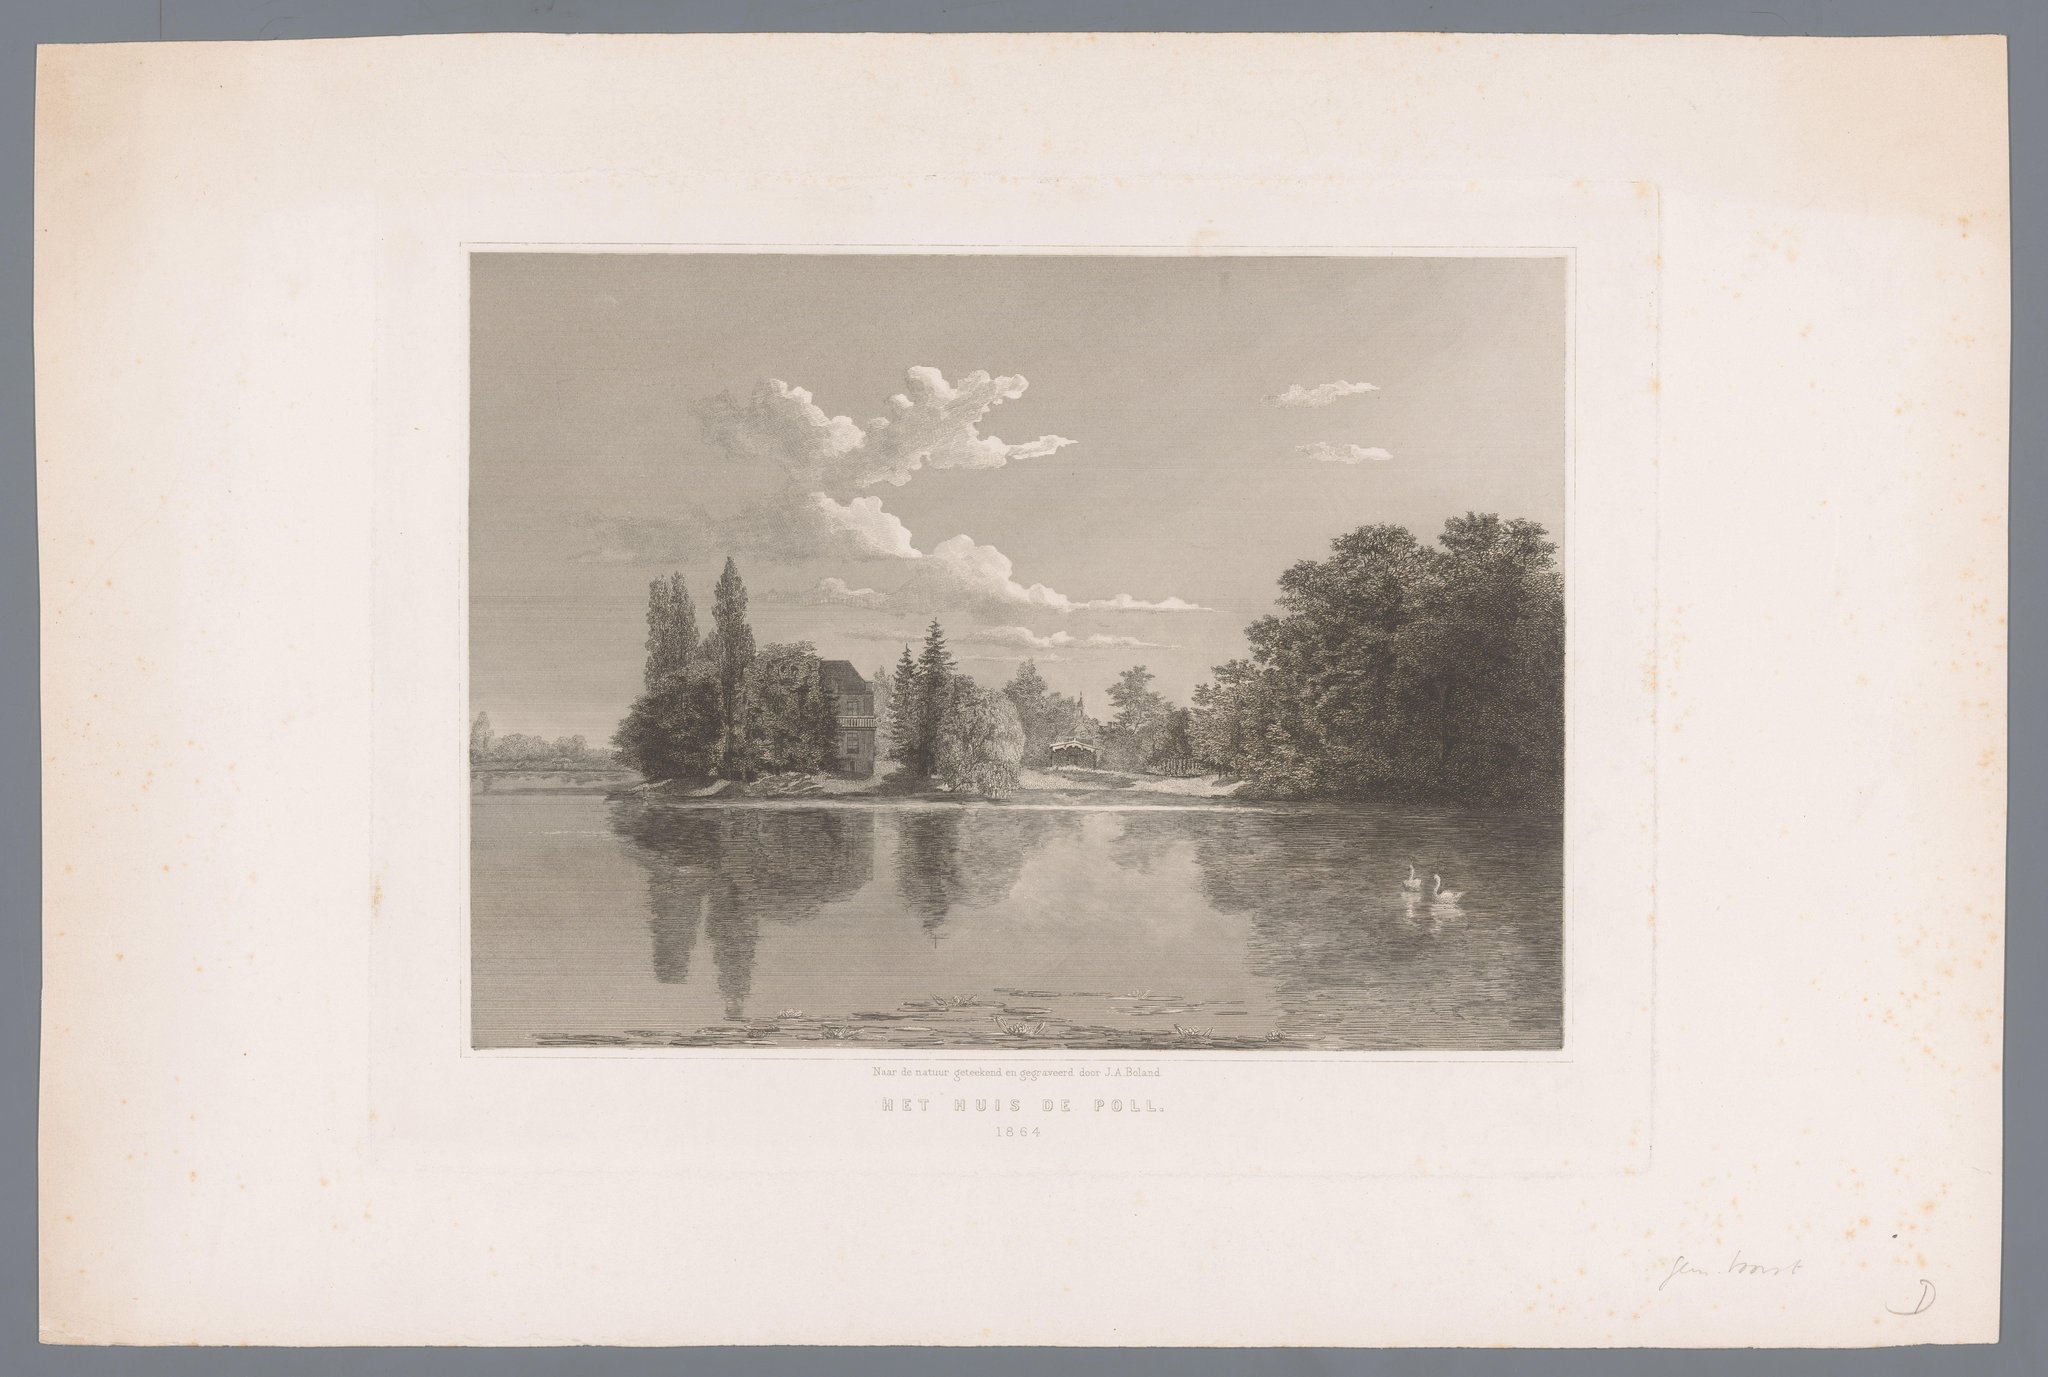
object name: print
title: Het Huis de Poll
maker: johannes arnoldus boland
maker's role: print maker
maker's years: 1838-1922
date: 1864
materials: paper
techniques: engraving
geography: amsterdam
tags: rural housing, e.g. country-house, villa, cottage, lake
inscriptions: date